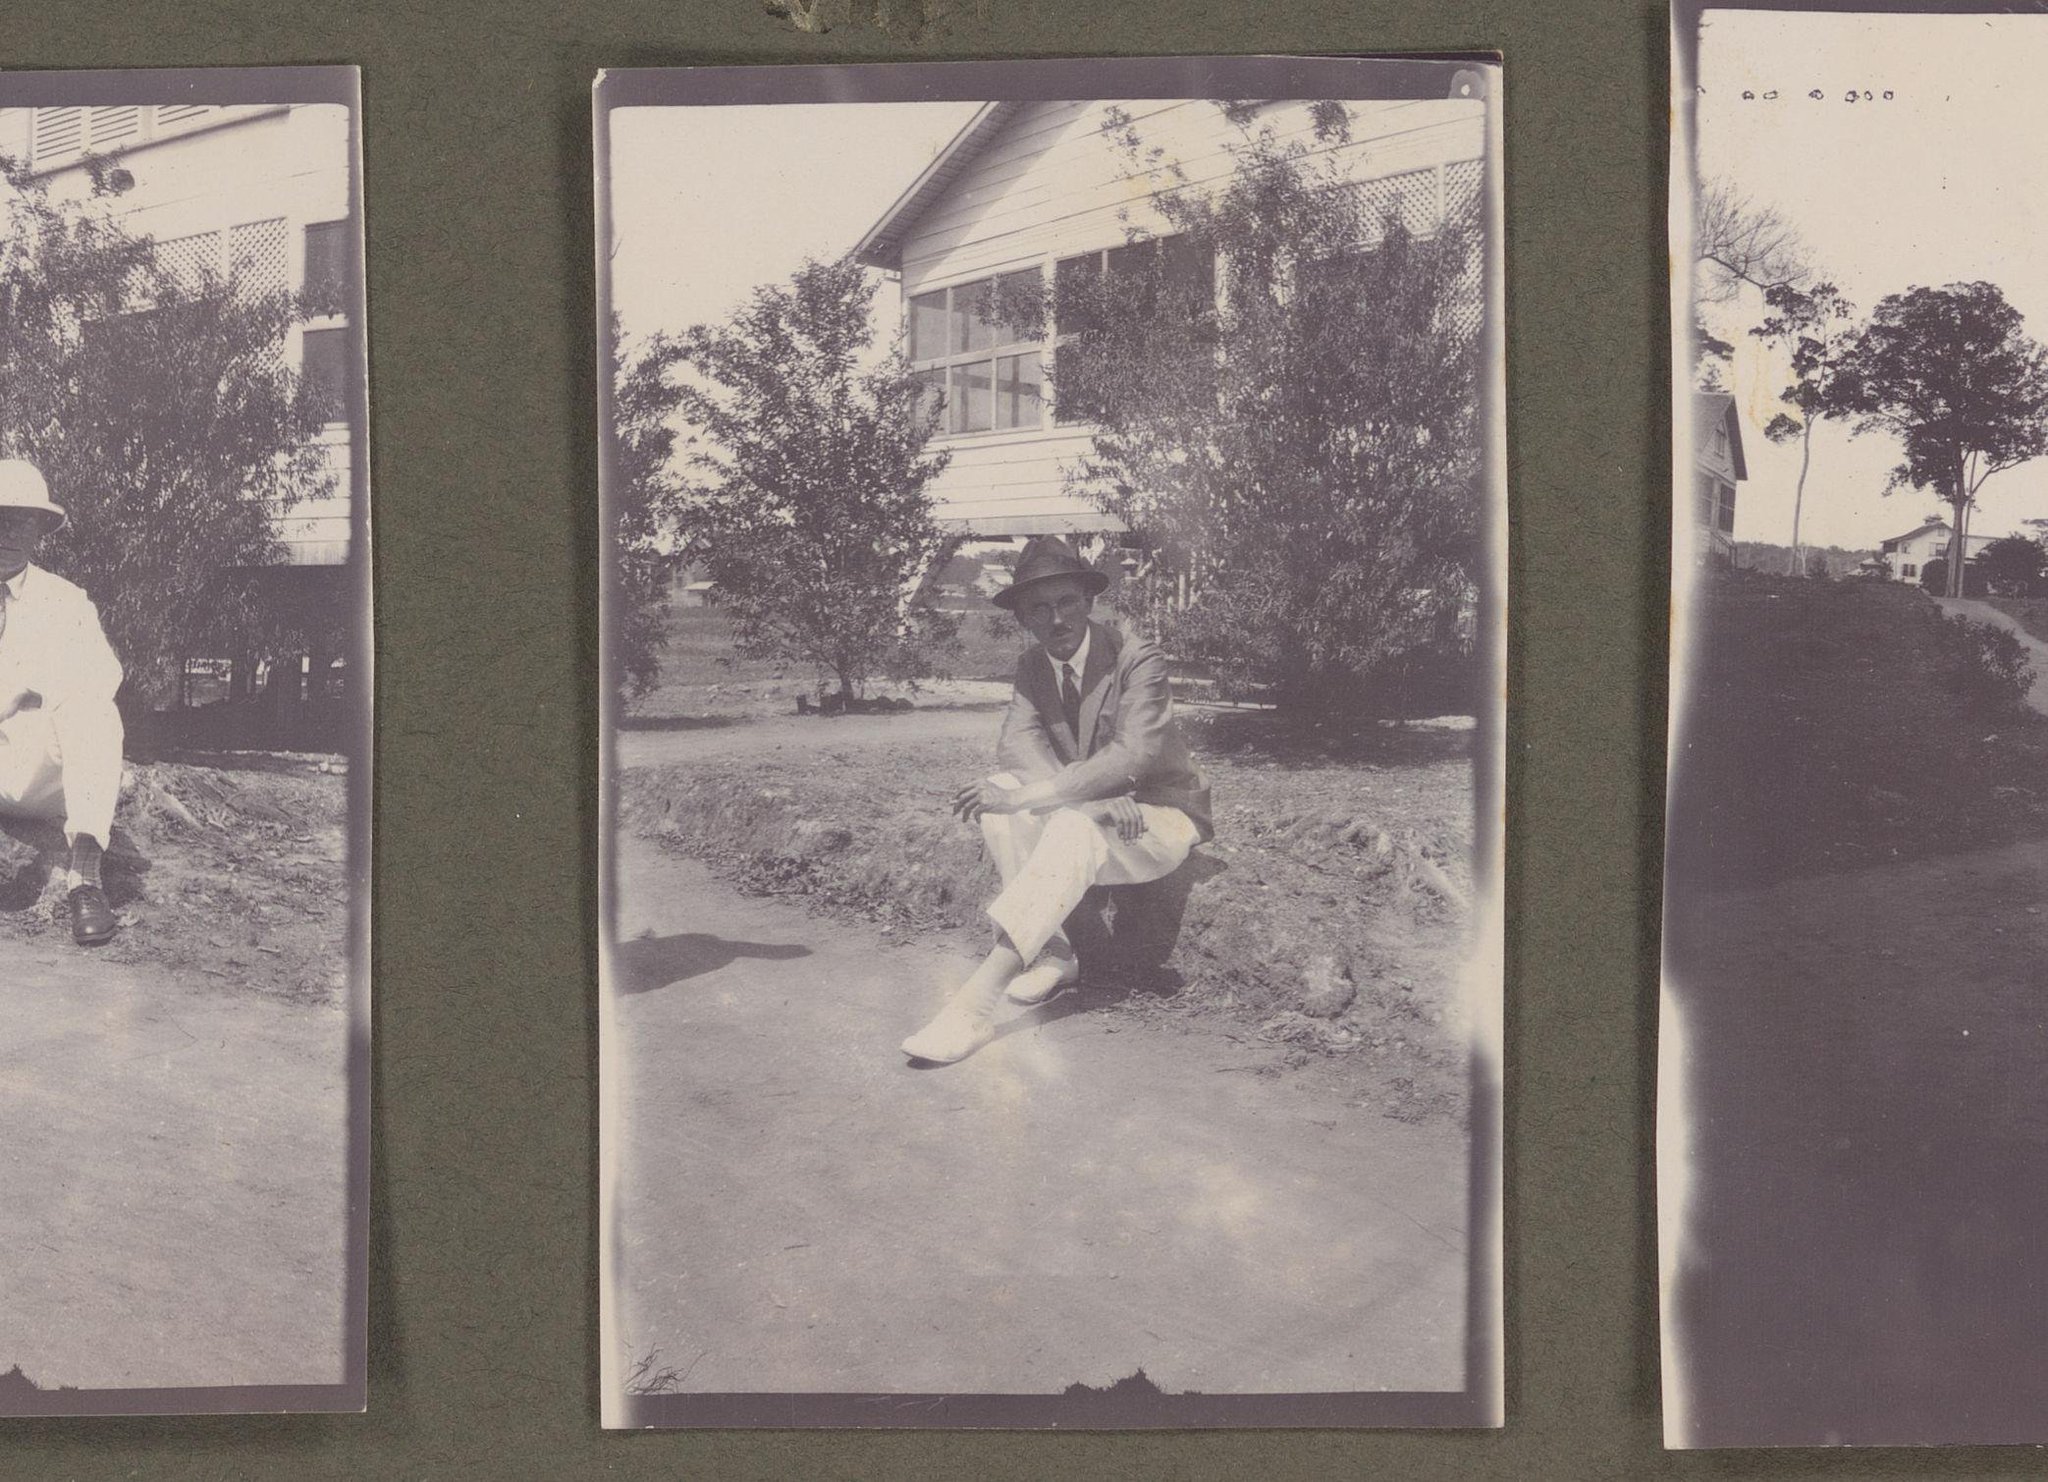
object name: photograph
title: Familiefoto te Moengo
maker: Anonymous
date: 1925-1927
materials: photographic support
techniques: photography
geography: suriname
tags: jetten, familie, moengo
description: Familiefoto met een zittende man te Moengo. Foto op een bladzijde van een los albumblad. Onderdeel van het ensemble met foto's van de familie van ingenieur Jetten in de mijnbouwstad Moengo in Suriname.